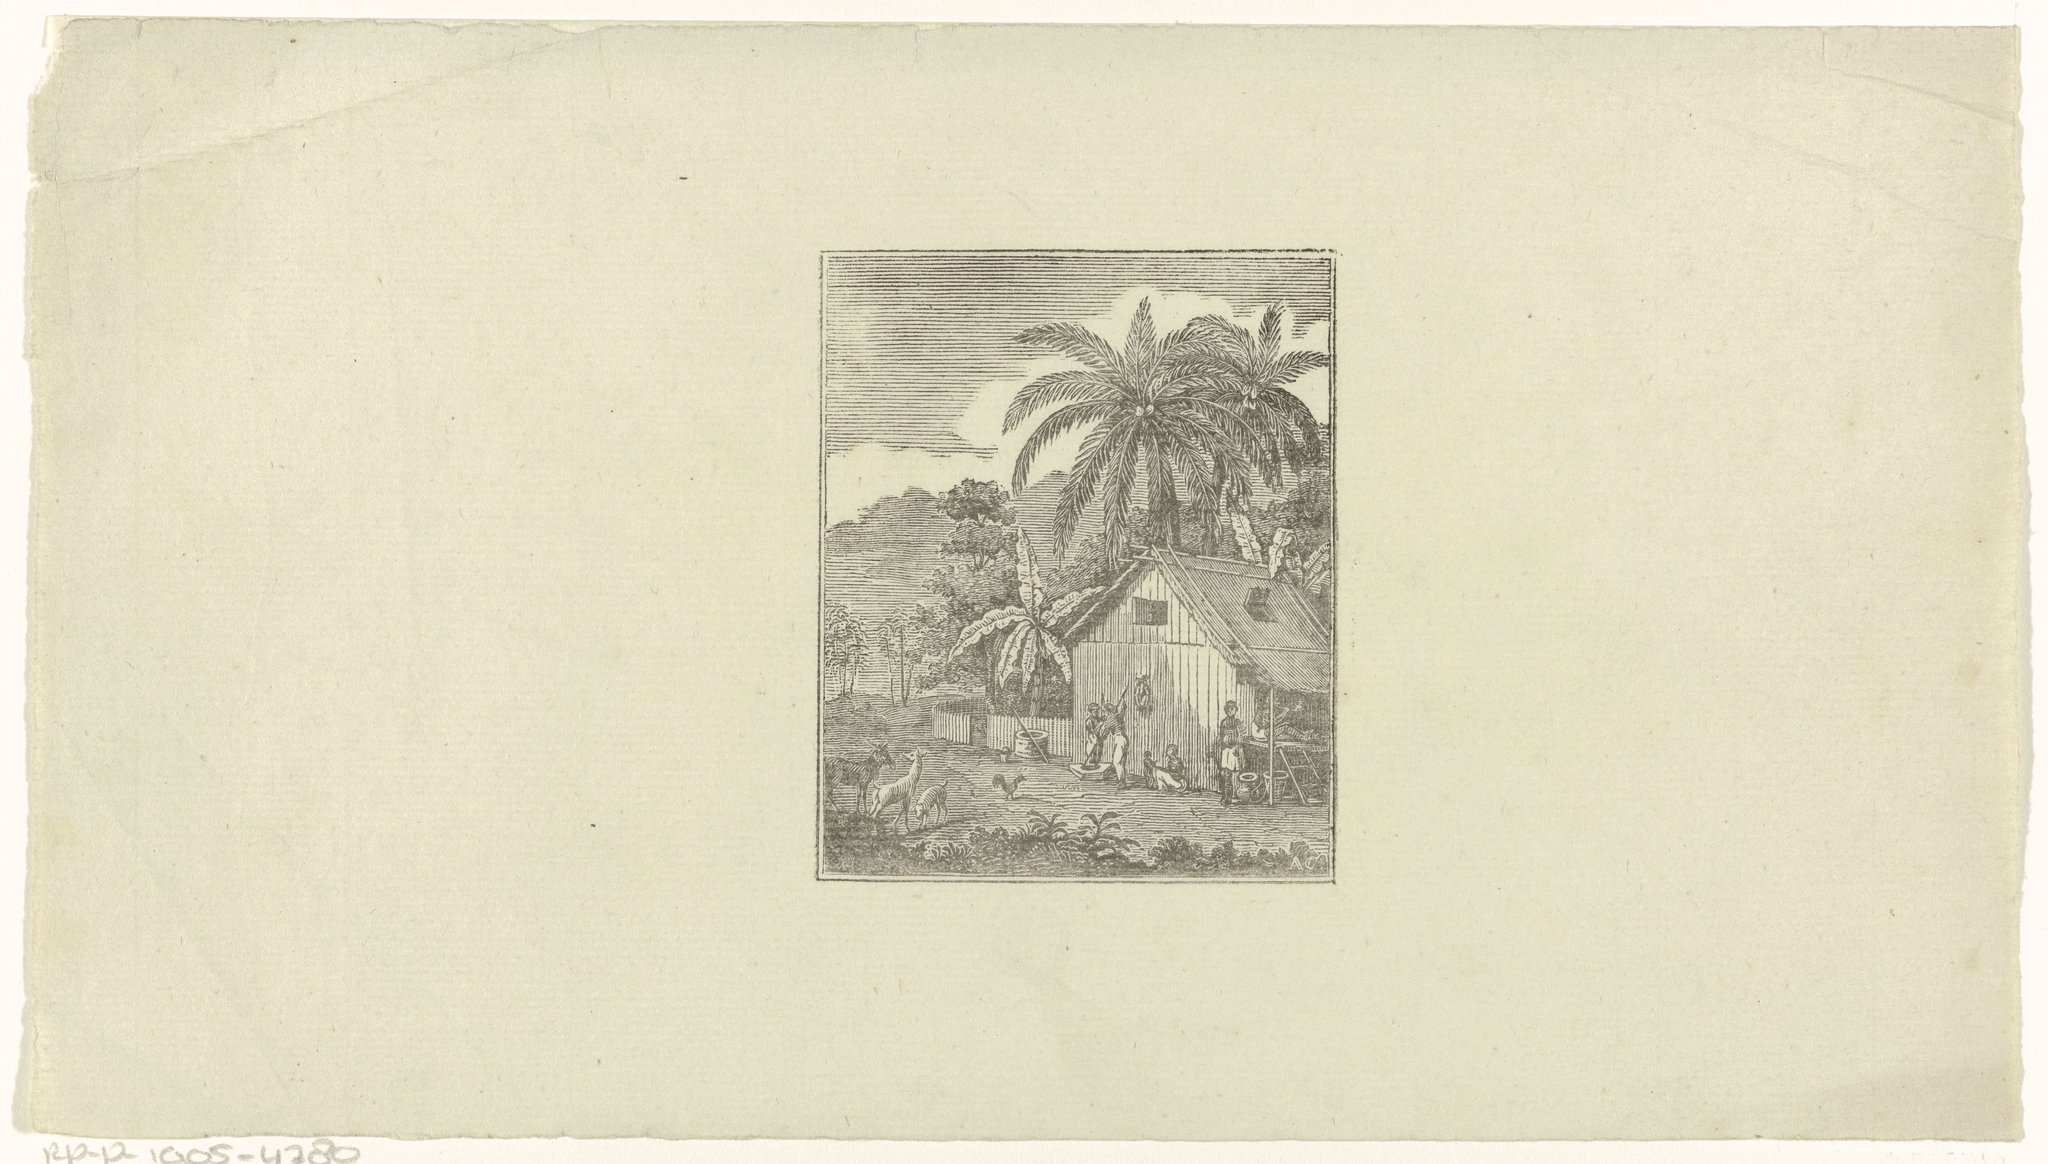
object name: print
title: Landschap met een huis onder kokospalmen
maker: alexander cranendoncq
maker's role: draughtsman, print maker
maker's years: 1799-1869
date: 1809-1869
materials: paper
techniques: engraving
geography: netherlands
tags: trees: coconut-tree, farm or solitary house in landscape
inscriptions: collector's mark: Lugt 2228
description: Voor het huis zijn figuren aan het werk en lopen dieren rond.